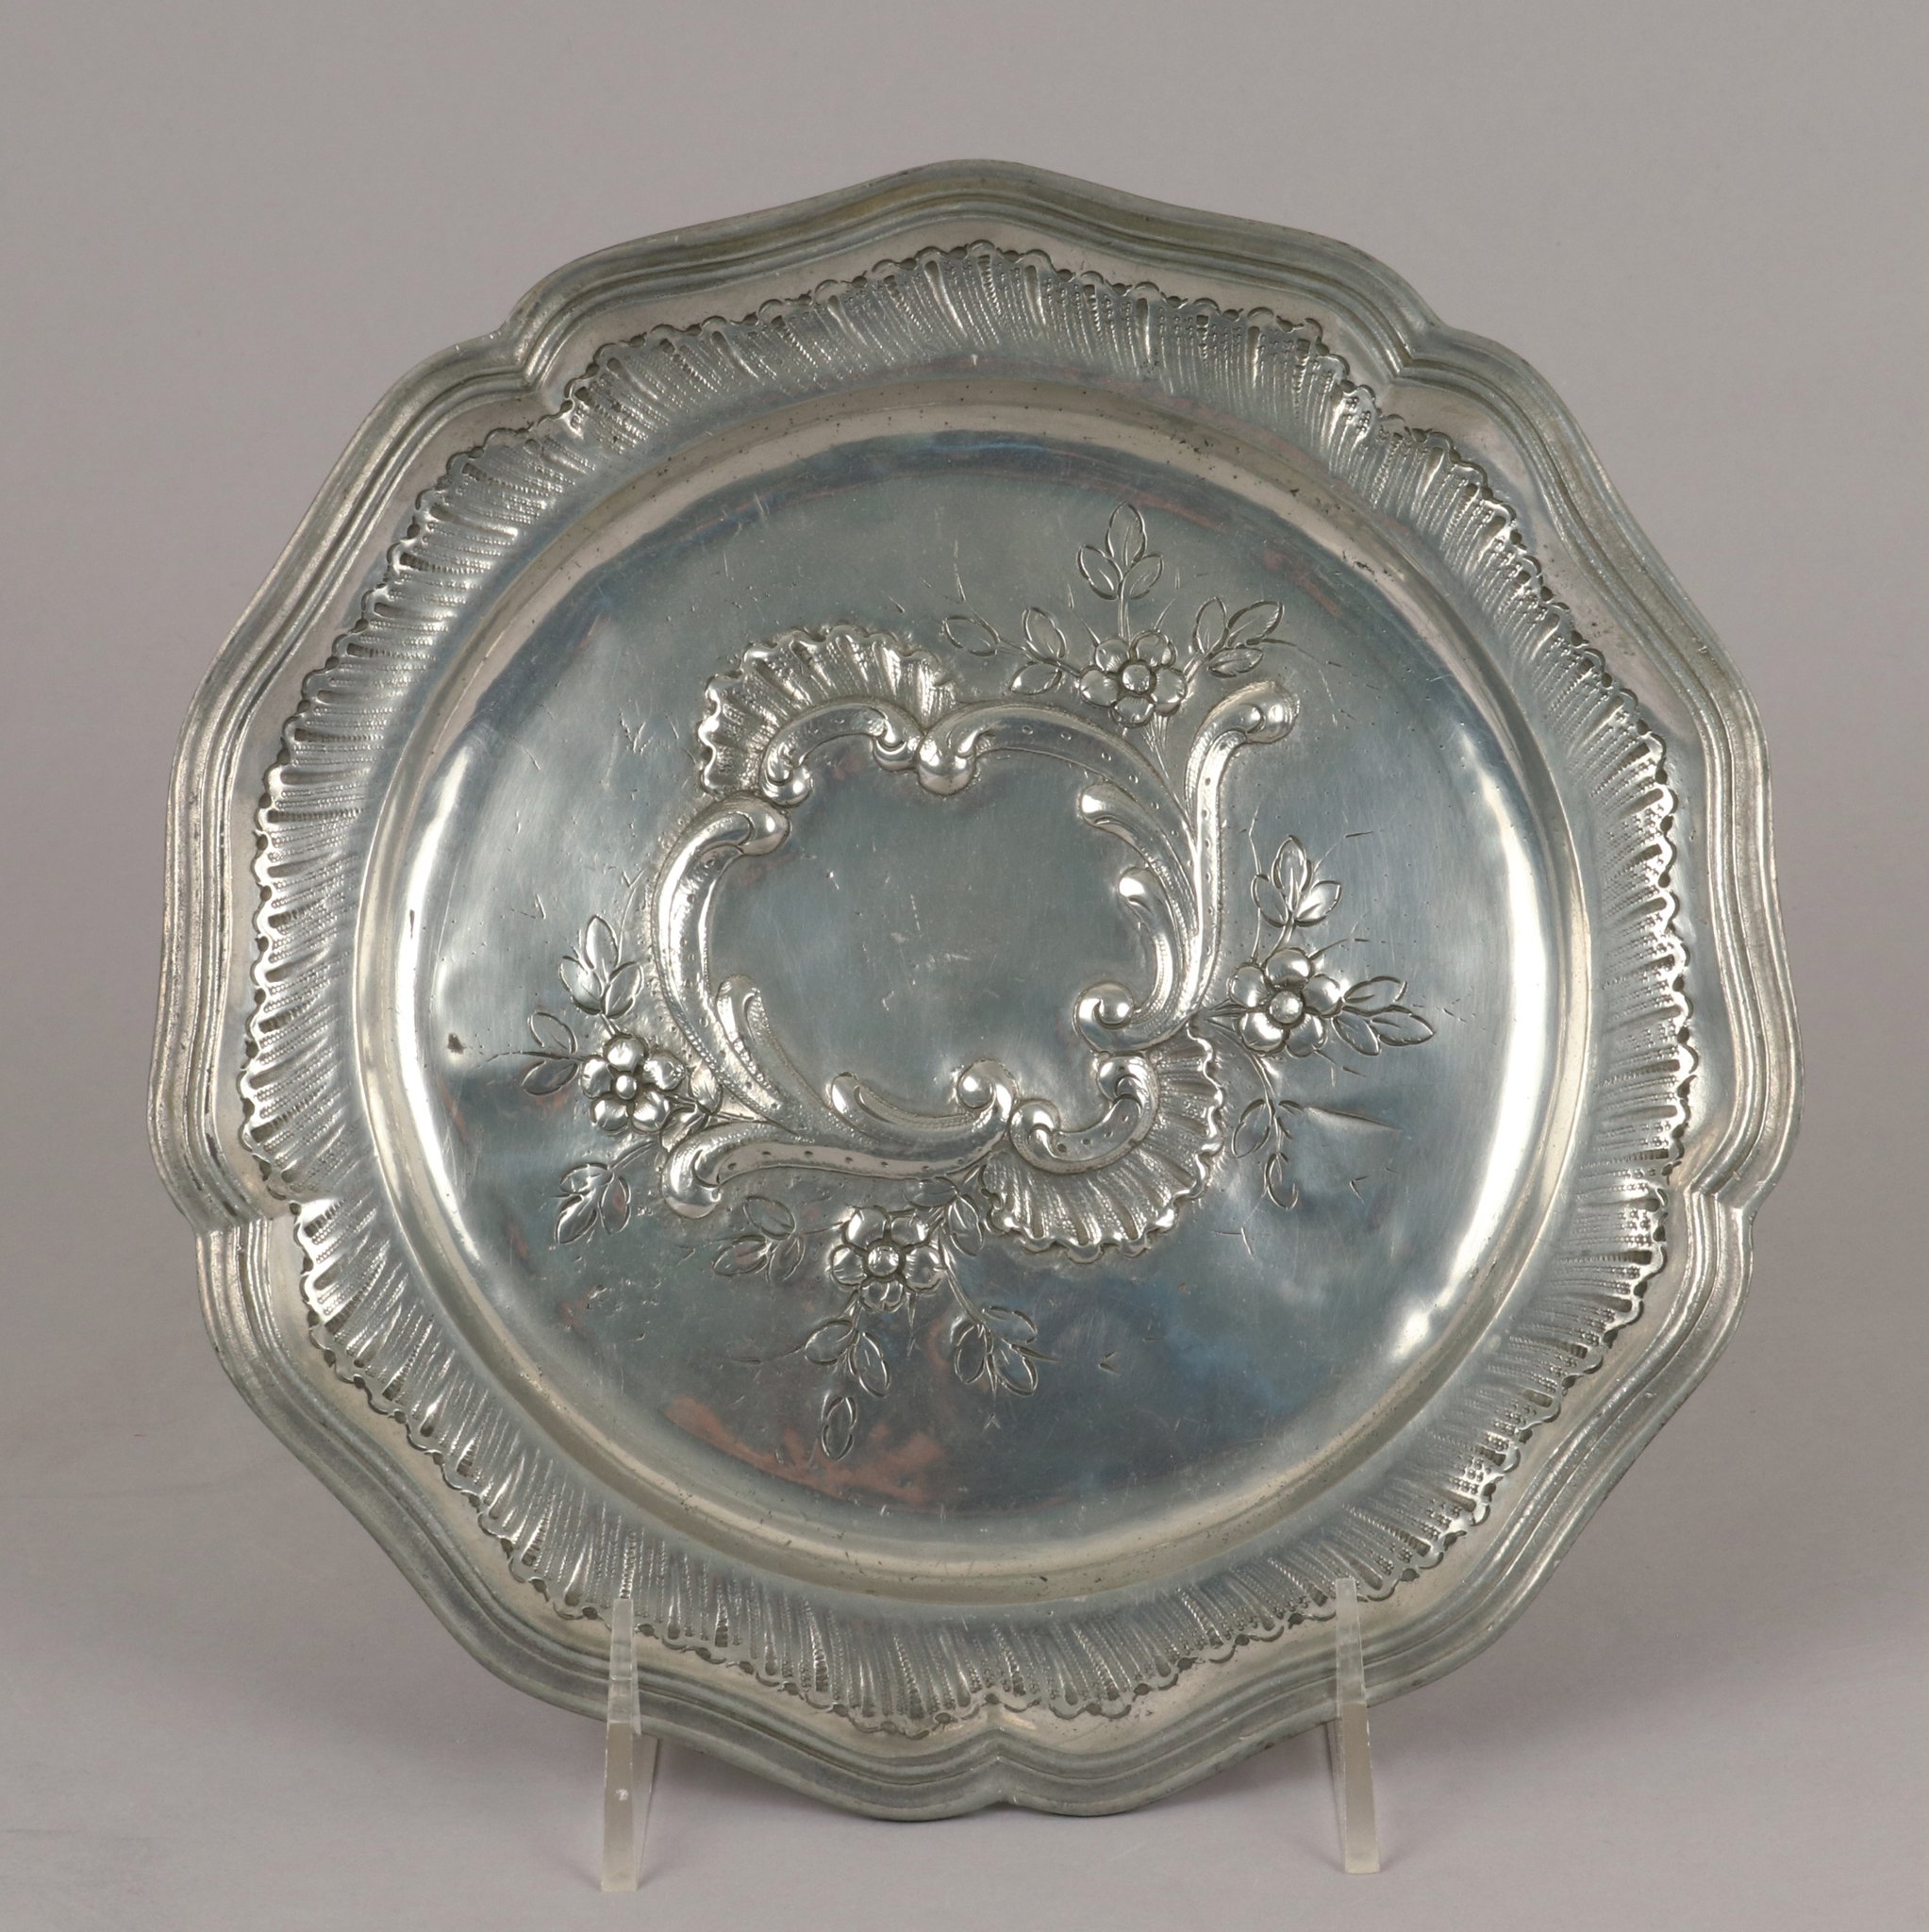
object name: plate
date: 1867-1900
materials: pewter